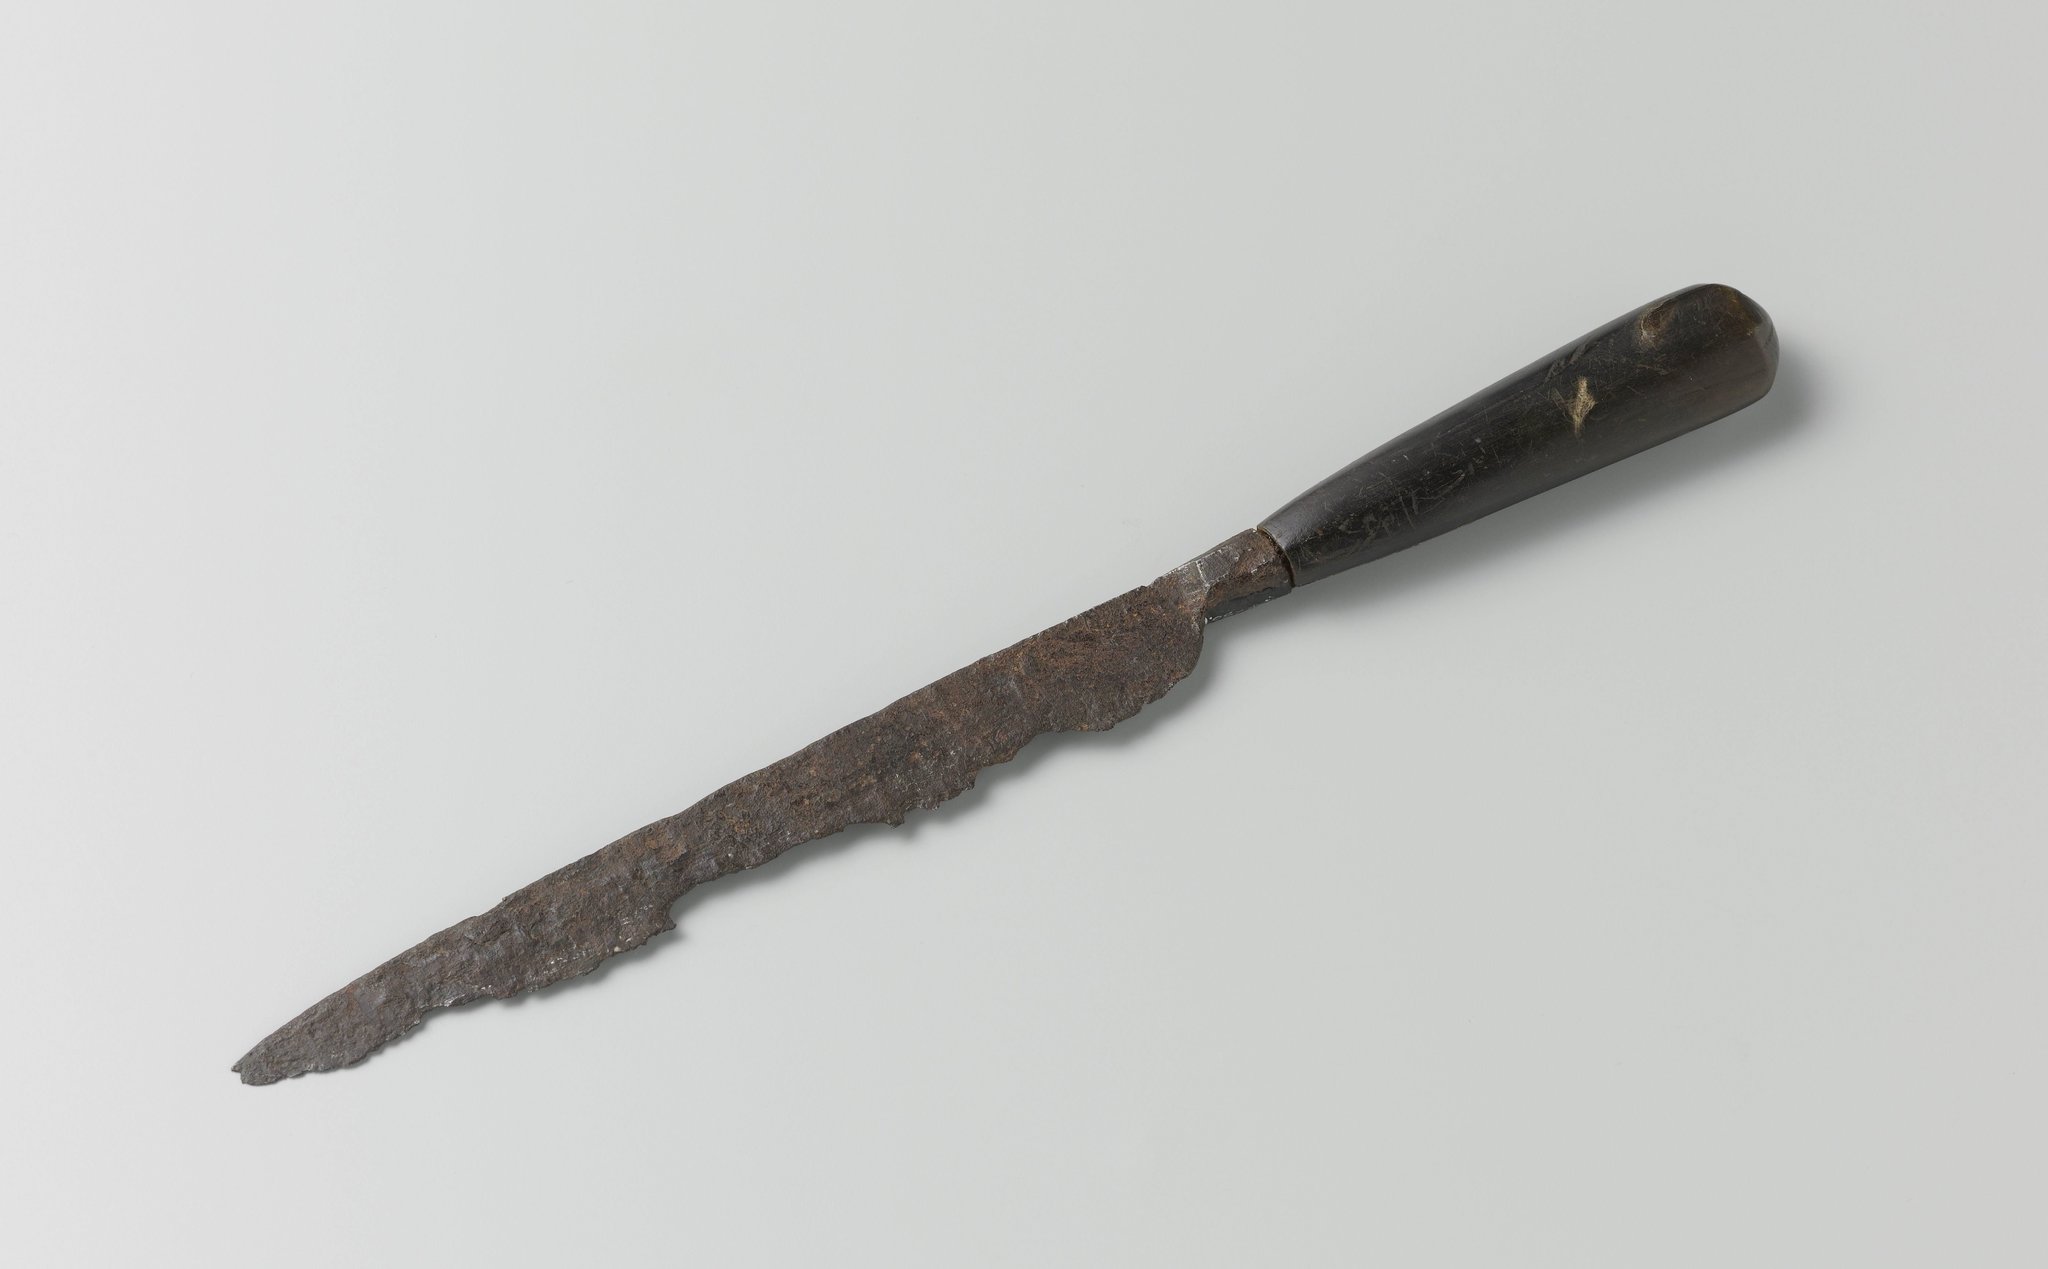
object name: table knife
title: Tafelmes met zeskantig heft van hoorn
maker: Anonymous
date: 1590-1596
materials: horn, iron, lead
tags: willem barendsz., amsterdam, jacob van heemskerck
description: Knives with horn and bone handles